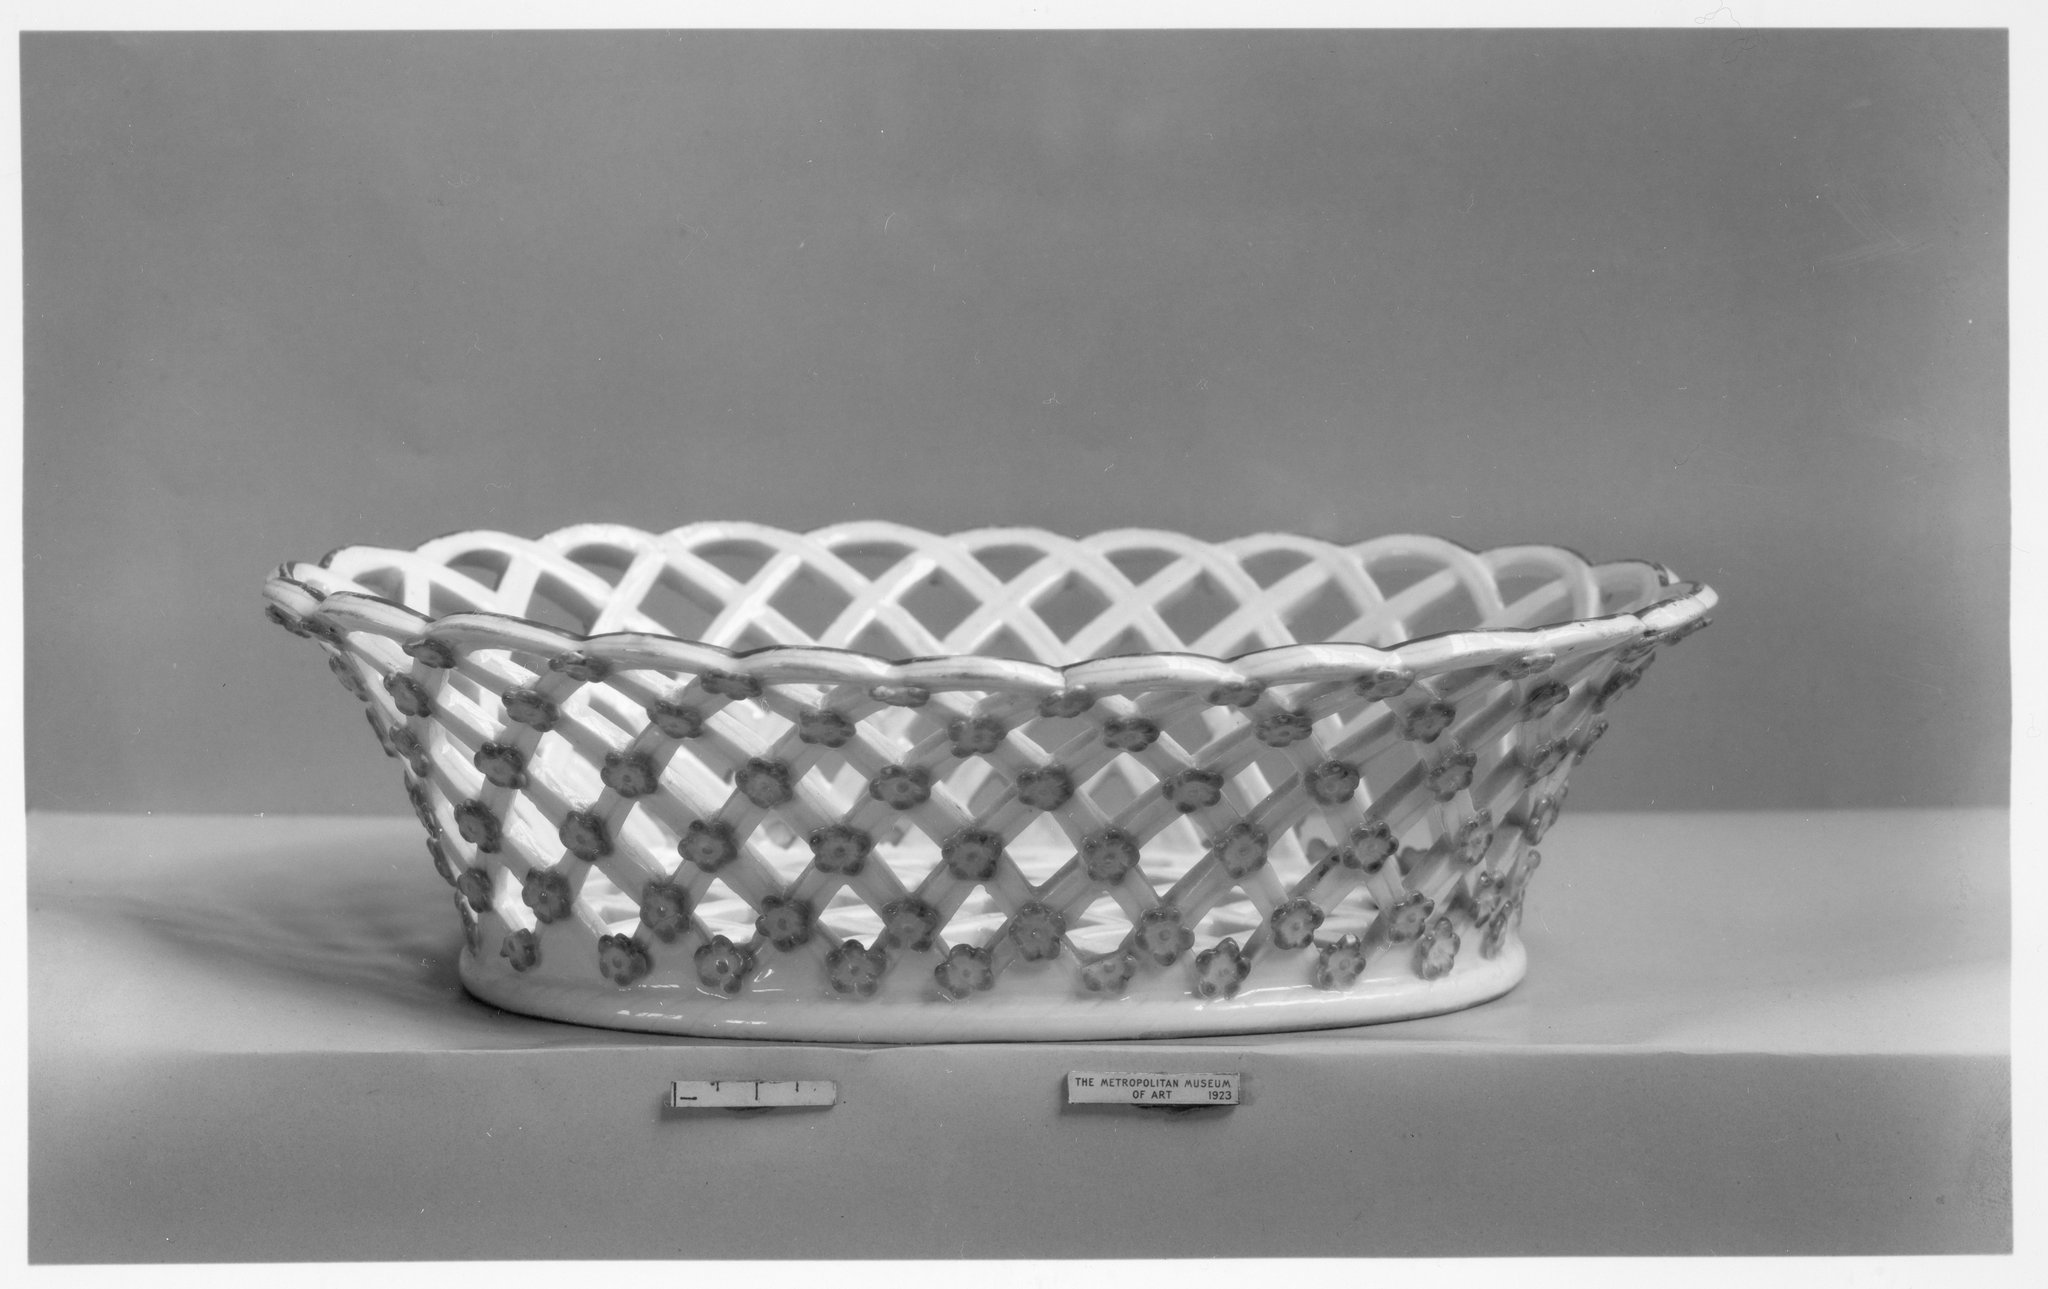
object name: dish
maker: meissen manufactory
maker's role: manufactory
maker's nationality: german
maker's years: 1710-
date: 1767-1800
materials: hard paste porcelain